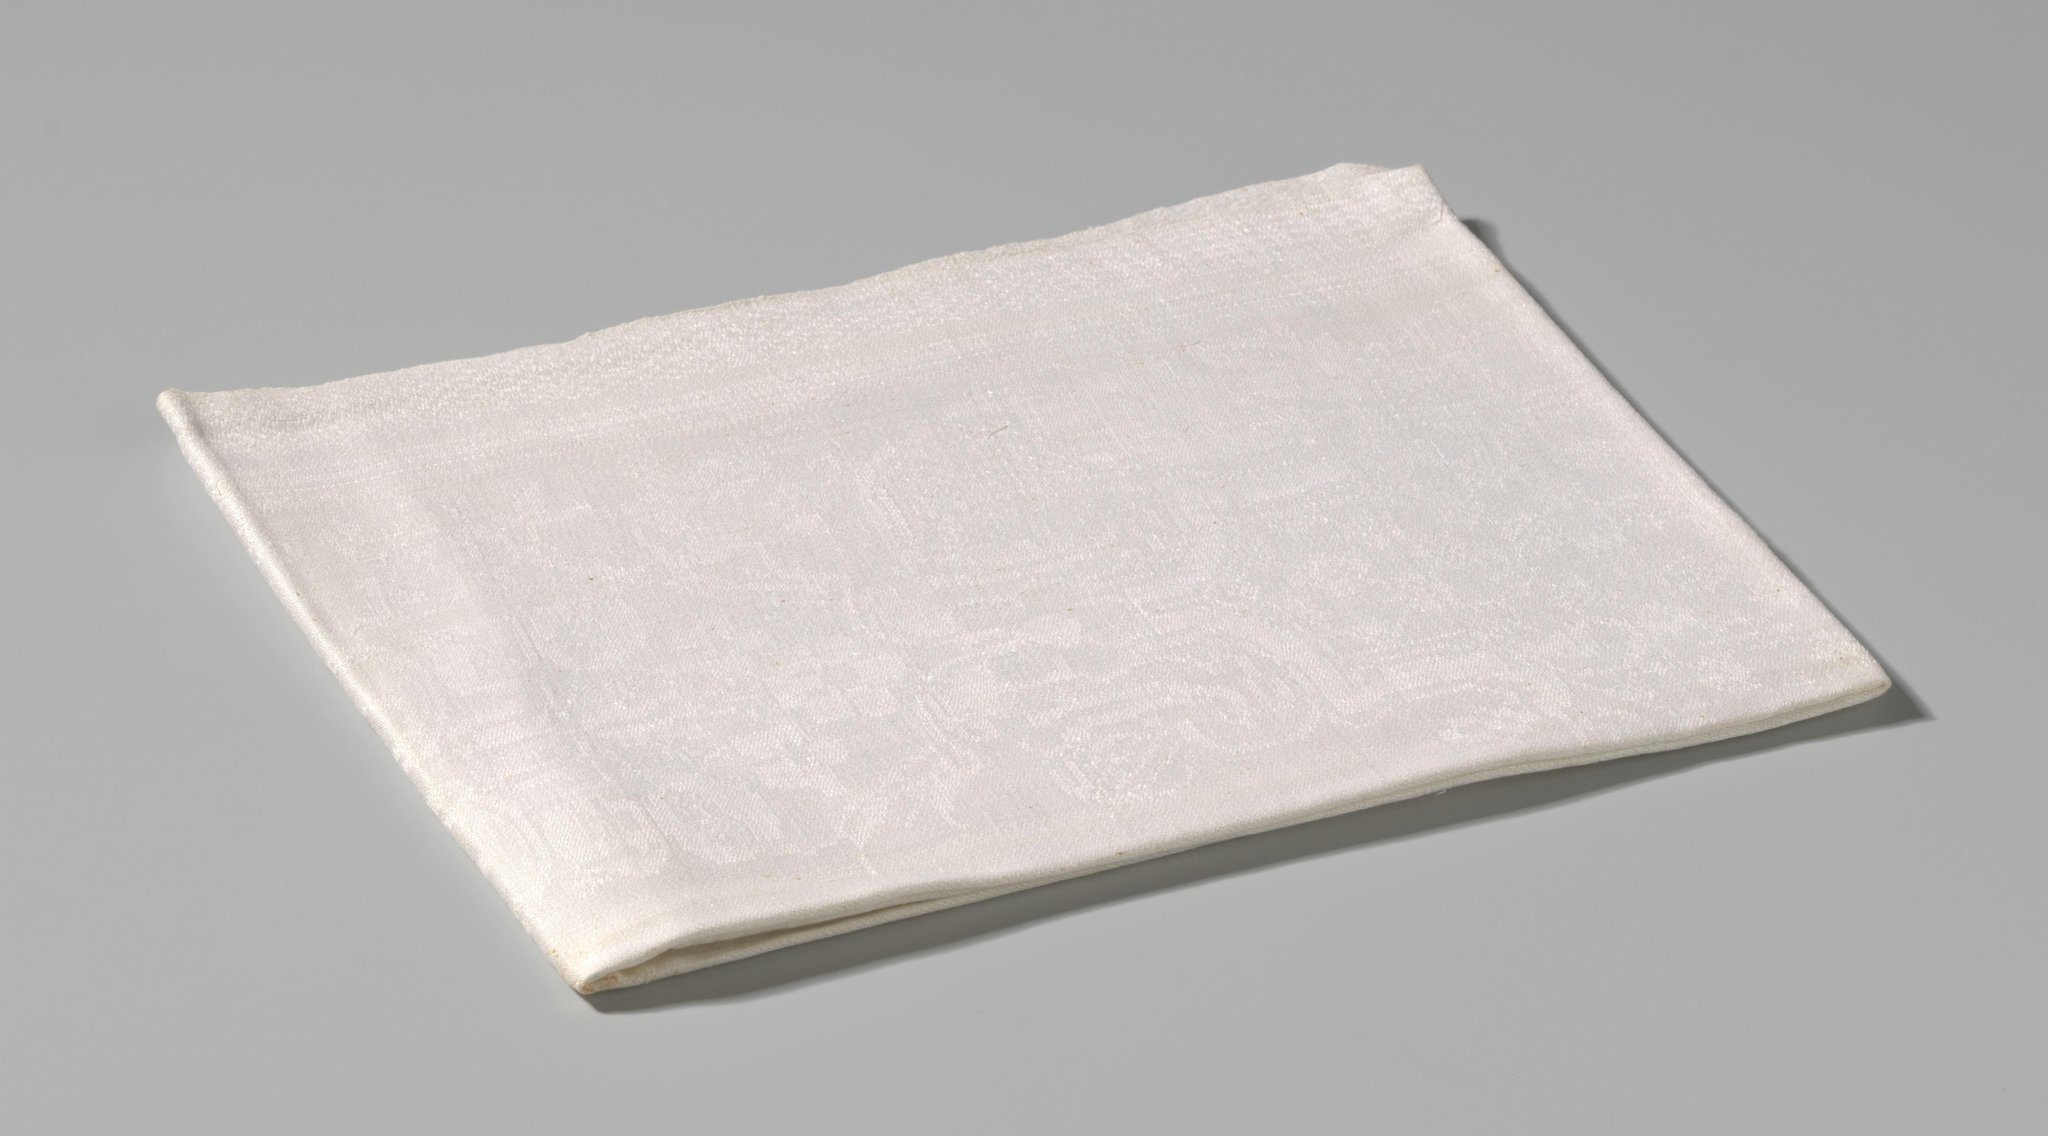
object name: napkin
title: Servet van linnendamast met een bloempatroon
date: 1725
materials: linen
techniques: damask, weave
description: Servet van linnendamast met bloemen en een regence-ornament. Het servet hoort bij negen servetten (BK-1974-87-A t/m BK-1974-87-J) en een tafellaken (BK-1974-86).